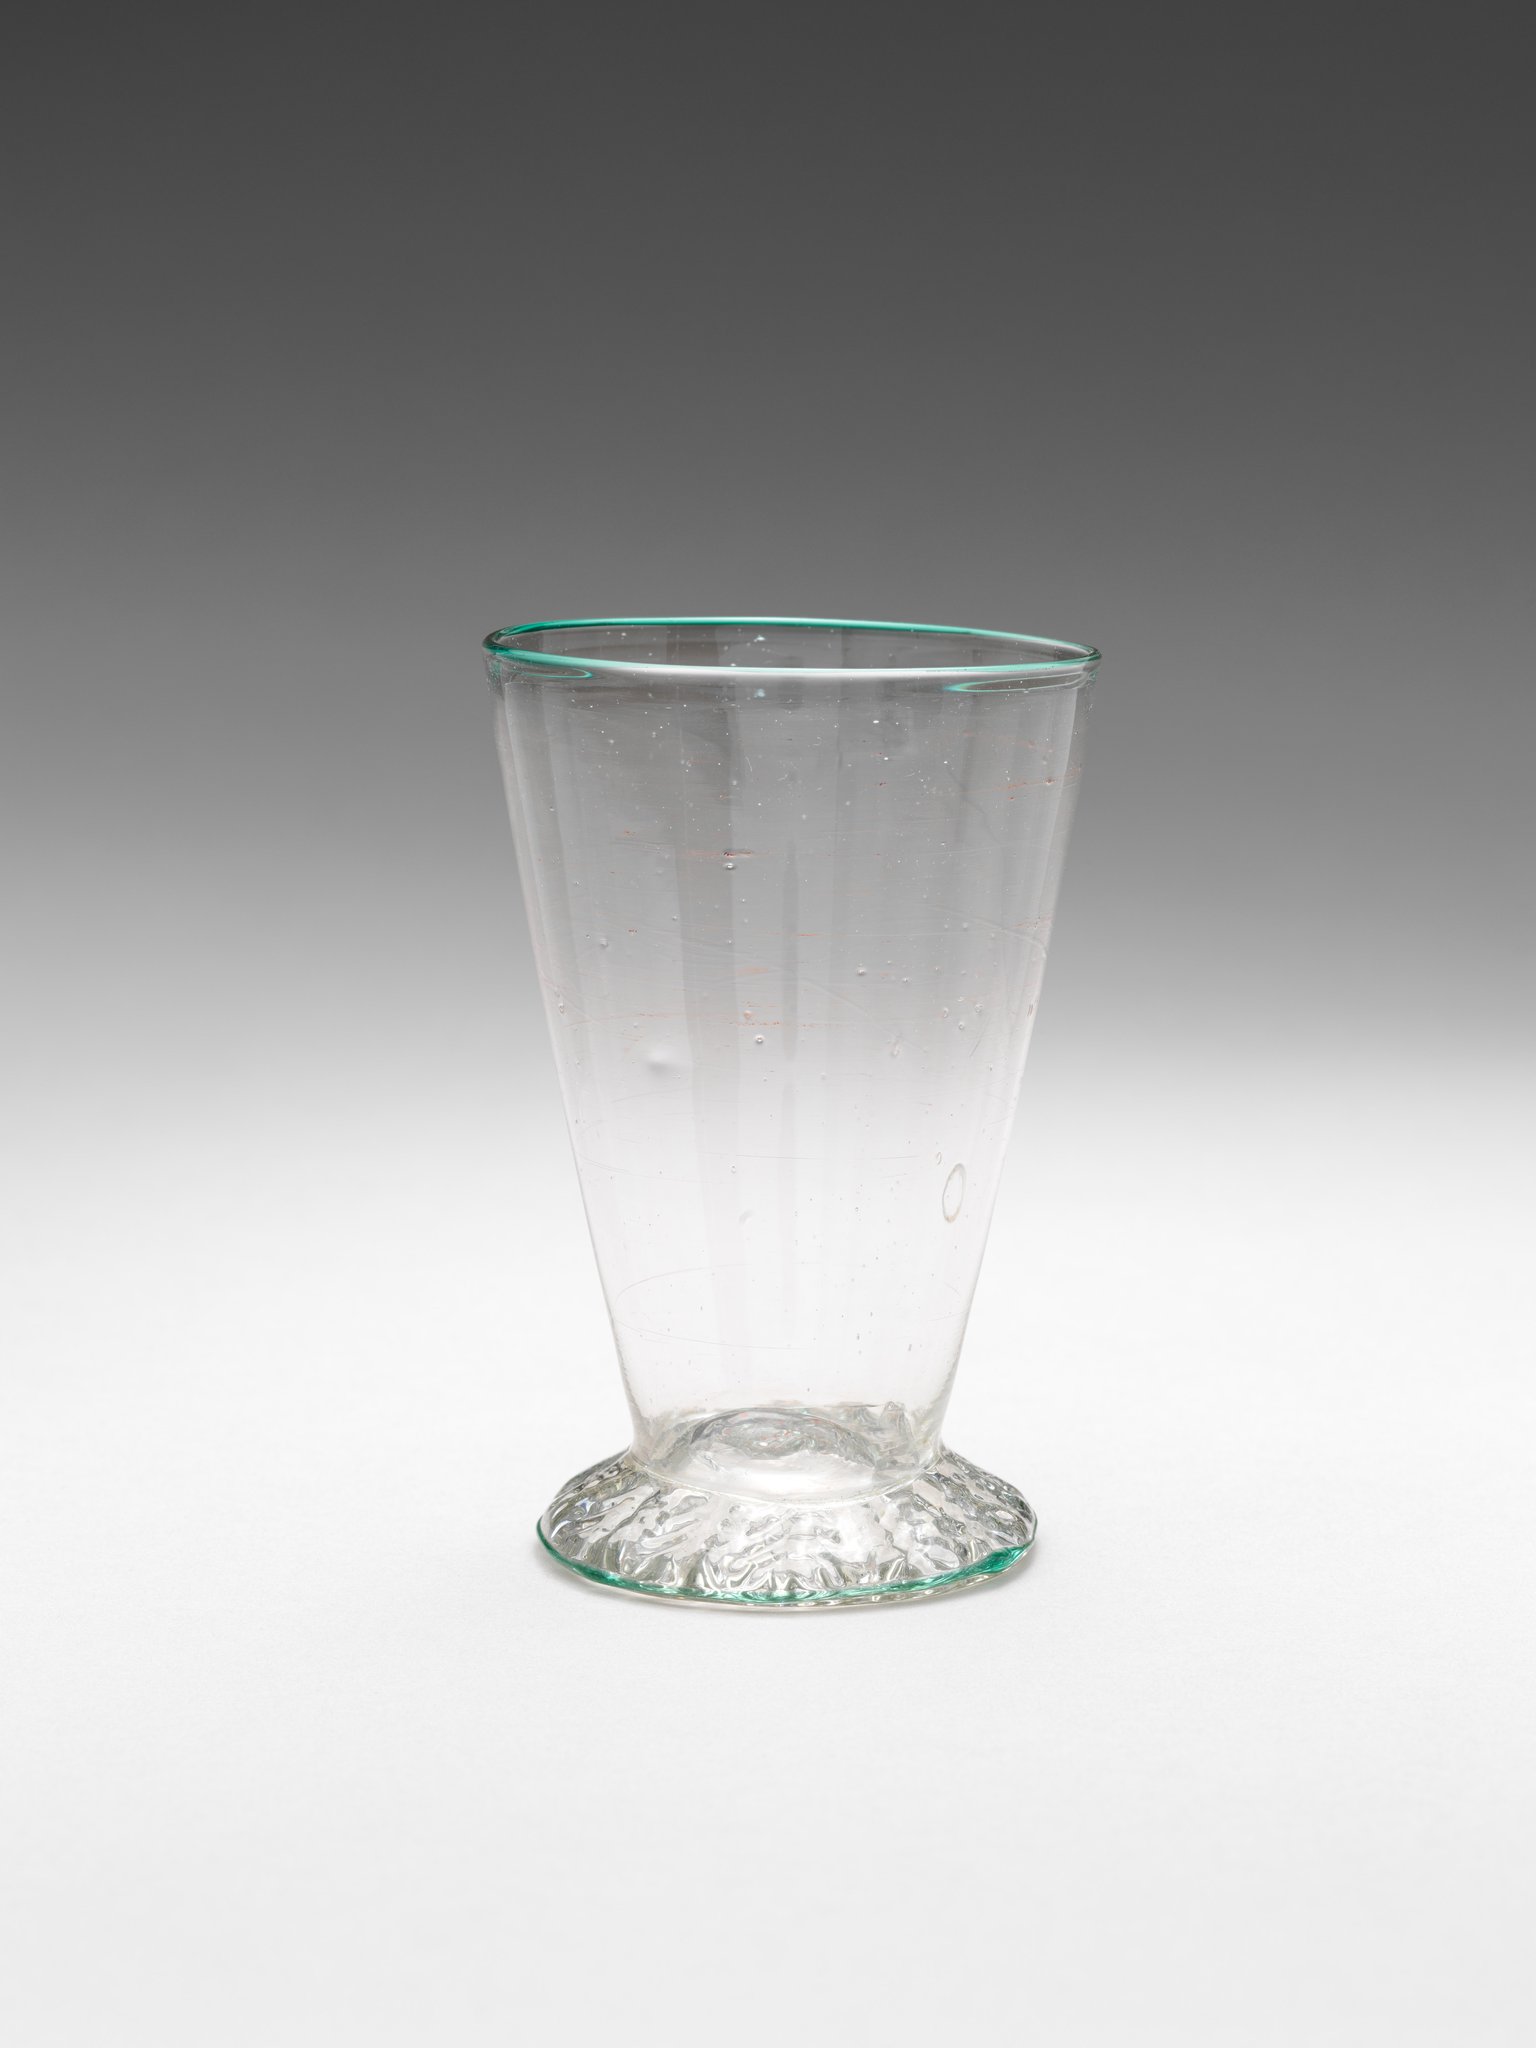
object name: beaker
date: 1701-1800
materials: glass